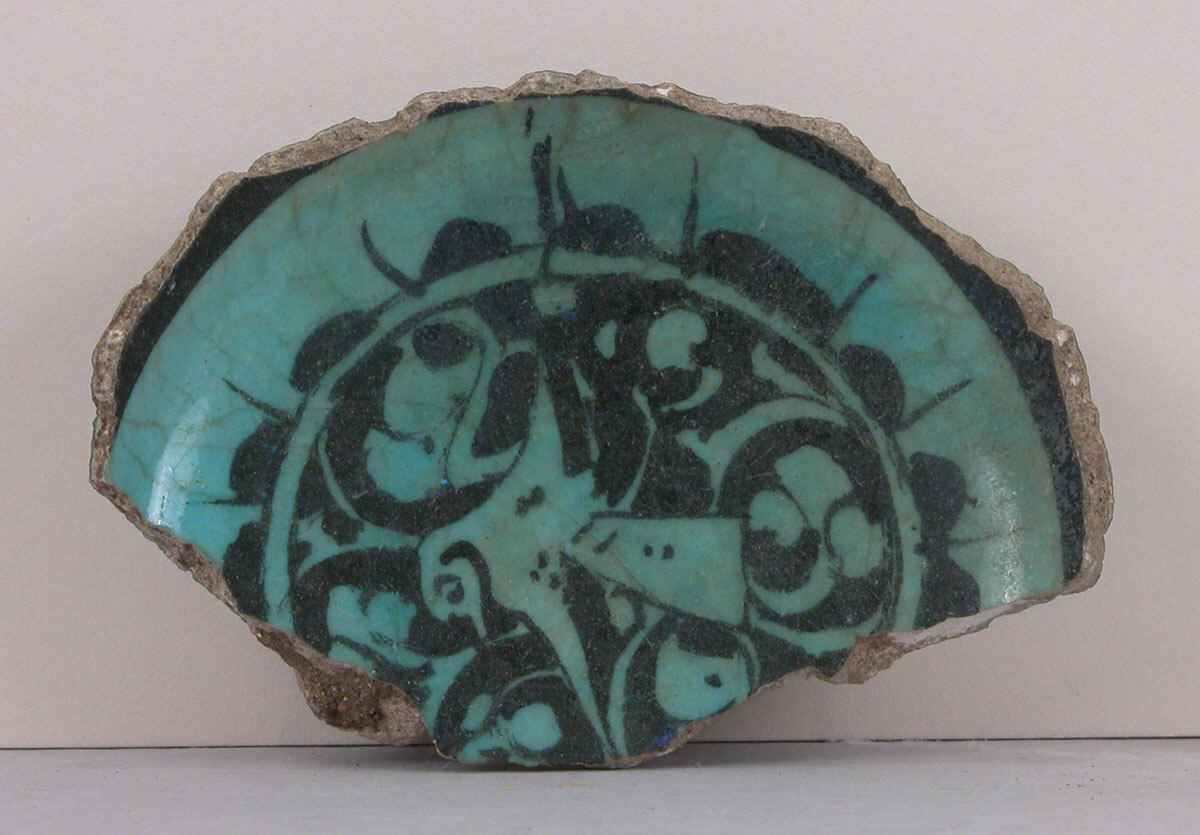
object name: fragment of a bowl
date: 1201-1300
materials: stonepaste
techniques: painting, underglaze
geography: syria